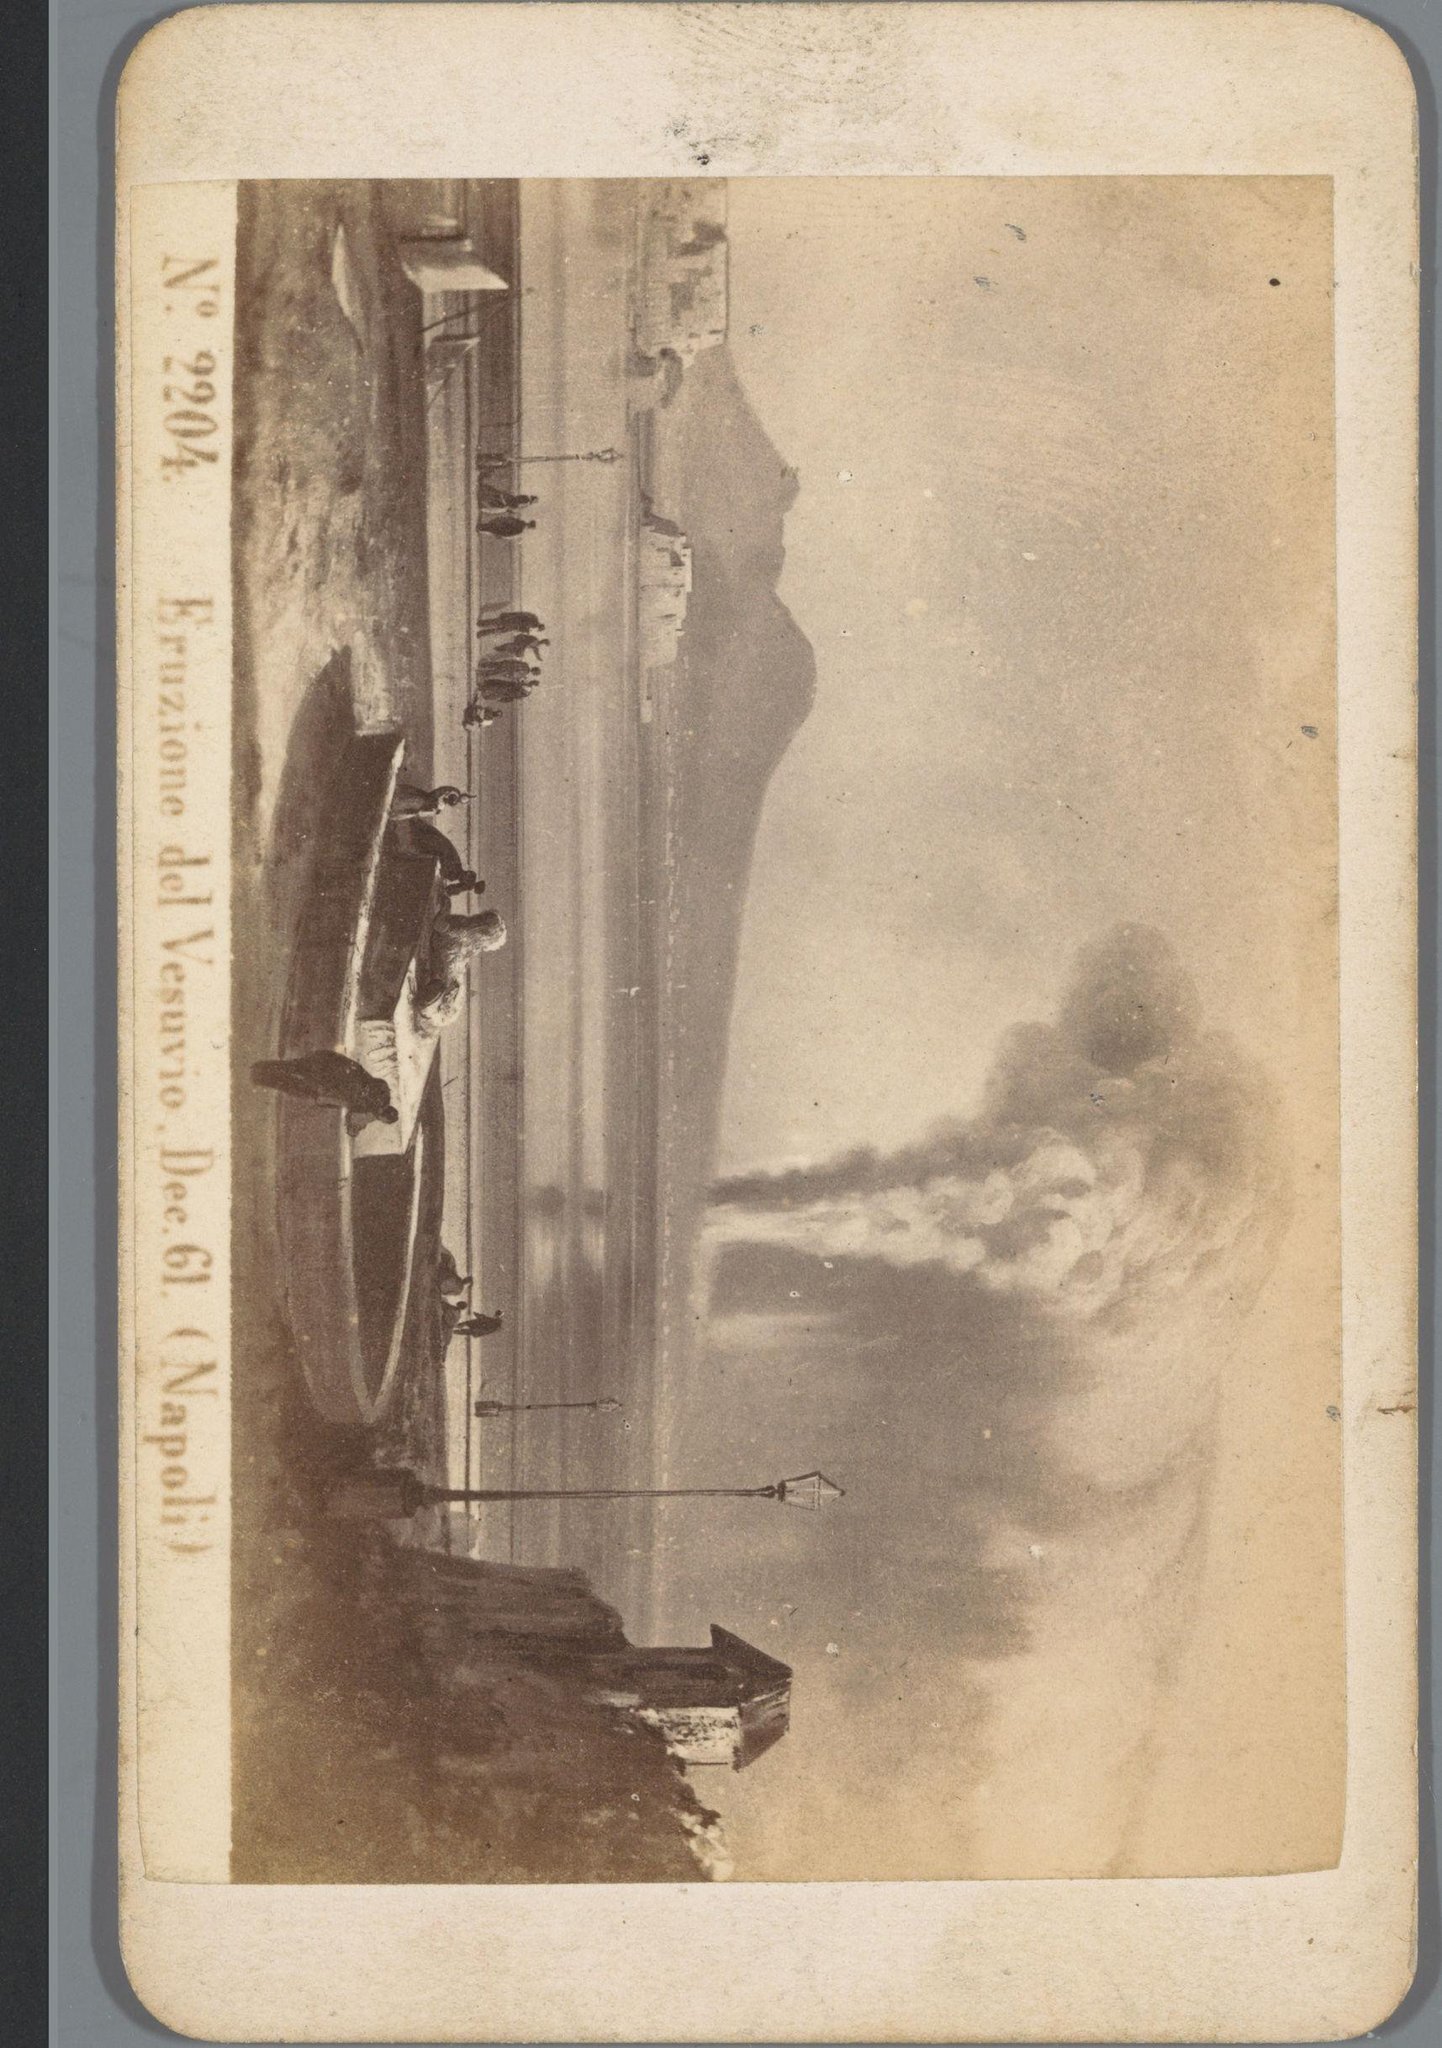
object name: carte de visite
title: Fotoreproductie van een schilderij van de uitbarsting van de Vesuvius in 1861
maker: giorgio sommer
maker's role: fotograaf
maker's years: 1834-1914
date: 1861-1888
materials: cardboard, paper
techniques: albumen print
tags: eruption (of volcano), mount vesuvius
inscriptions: number: ‘No. 2204’